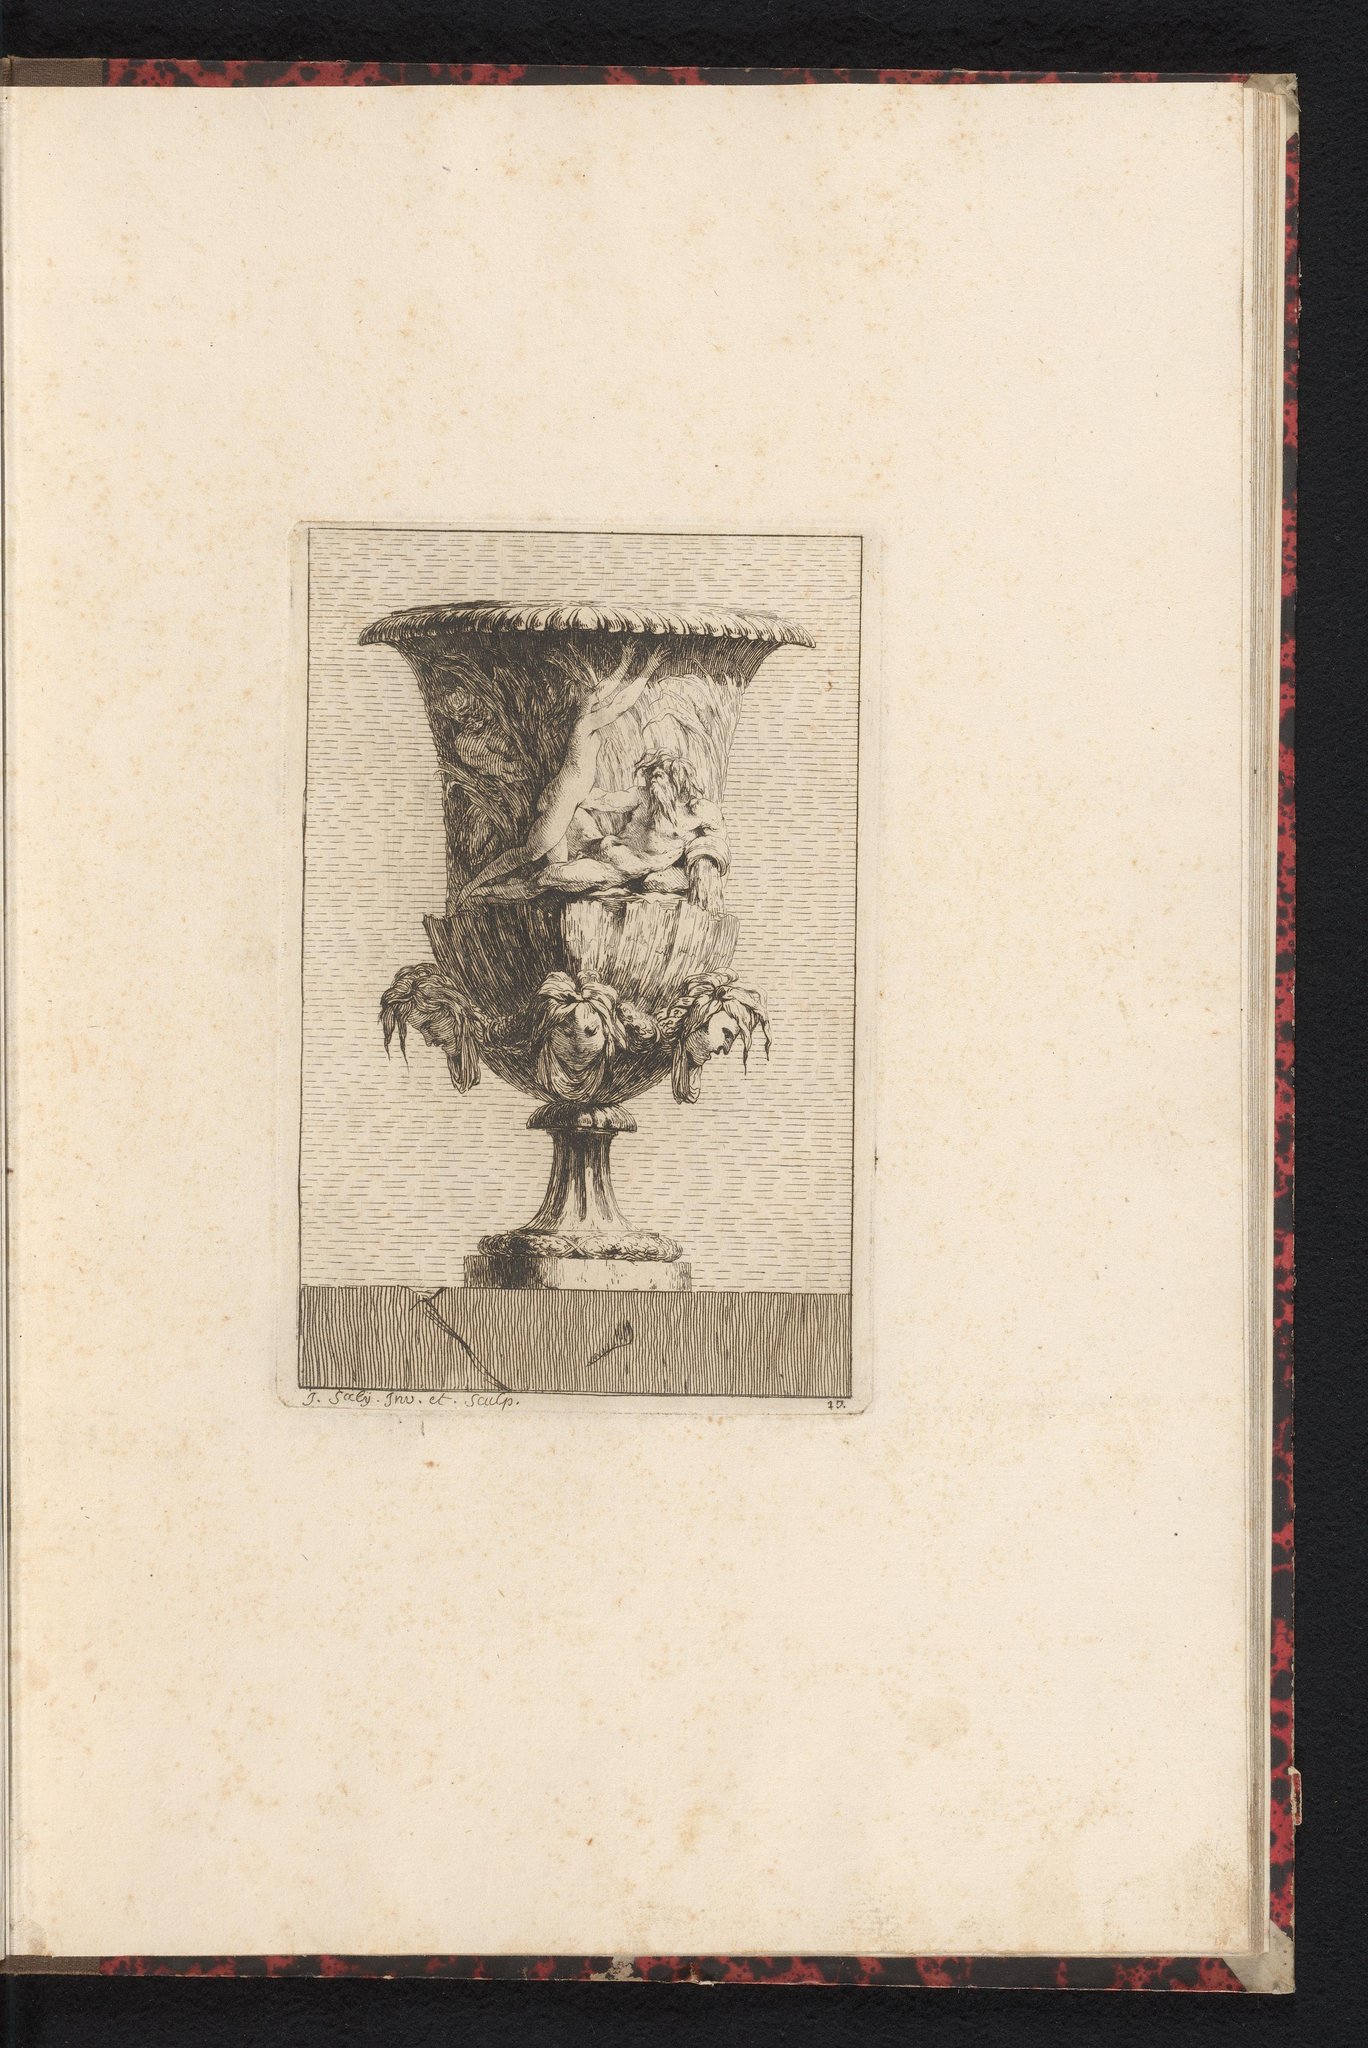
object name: print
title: Vaas met Pan en Syrinx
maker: jacques francois joseph saly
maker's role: print maker, sculptor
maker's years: 1717-1776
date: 1746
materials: paper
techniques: etching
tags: naiads, river- and spring-nymphs; usually carrying an urn; 'naiadi, ninfe de' fiumi' (ripa), syrinx changed into a reed: while fleeing from pan, the nymph syrinx is changed into reed by her sisters, the naiads (ovid, metamorphoses i 705), garden vase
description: De buik van de vaas is gedecoreerd met drie vrouwenhoofden (mogelijk naiaden). Deze prent maakt deel uit van een album.